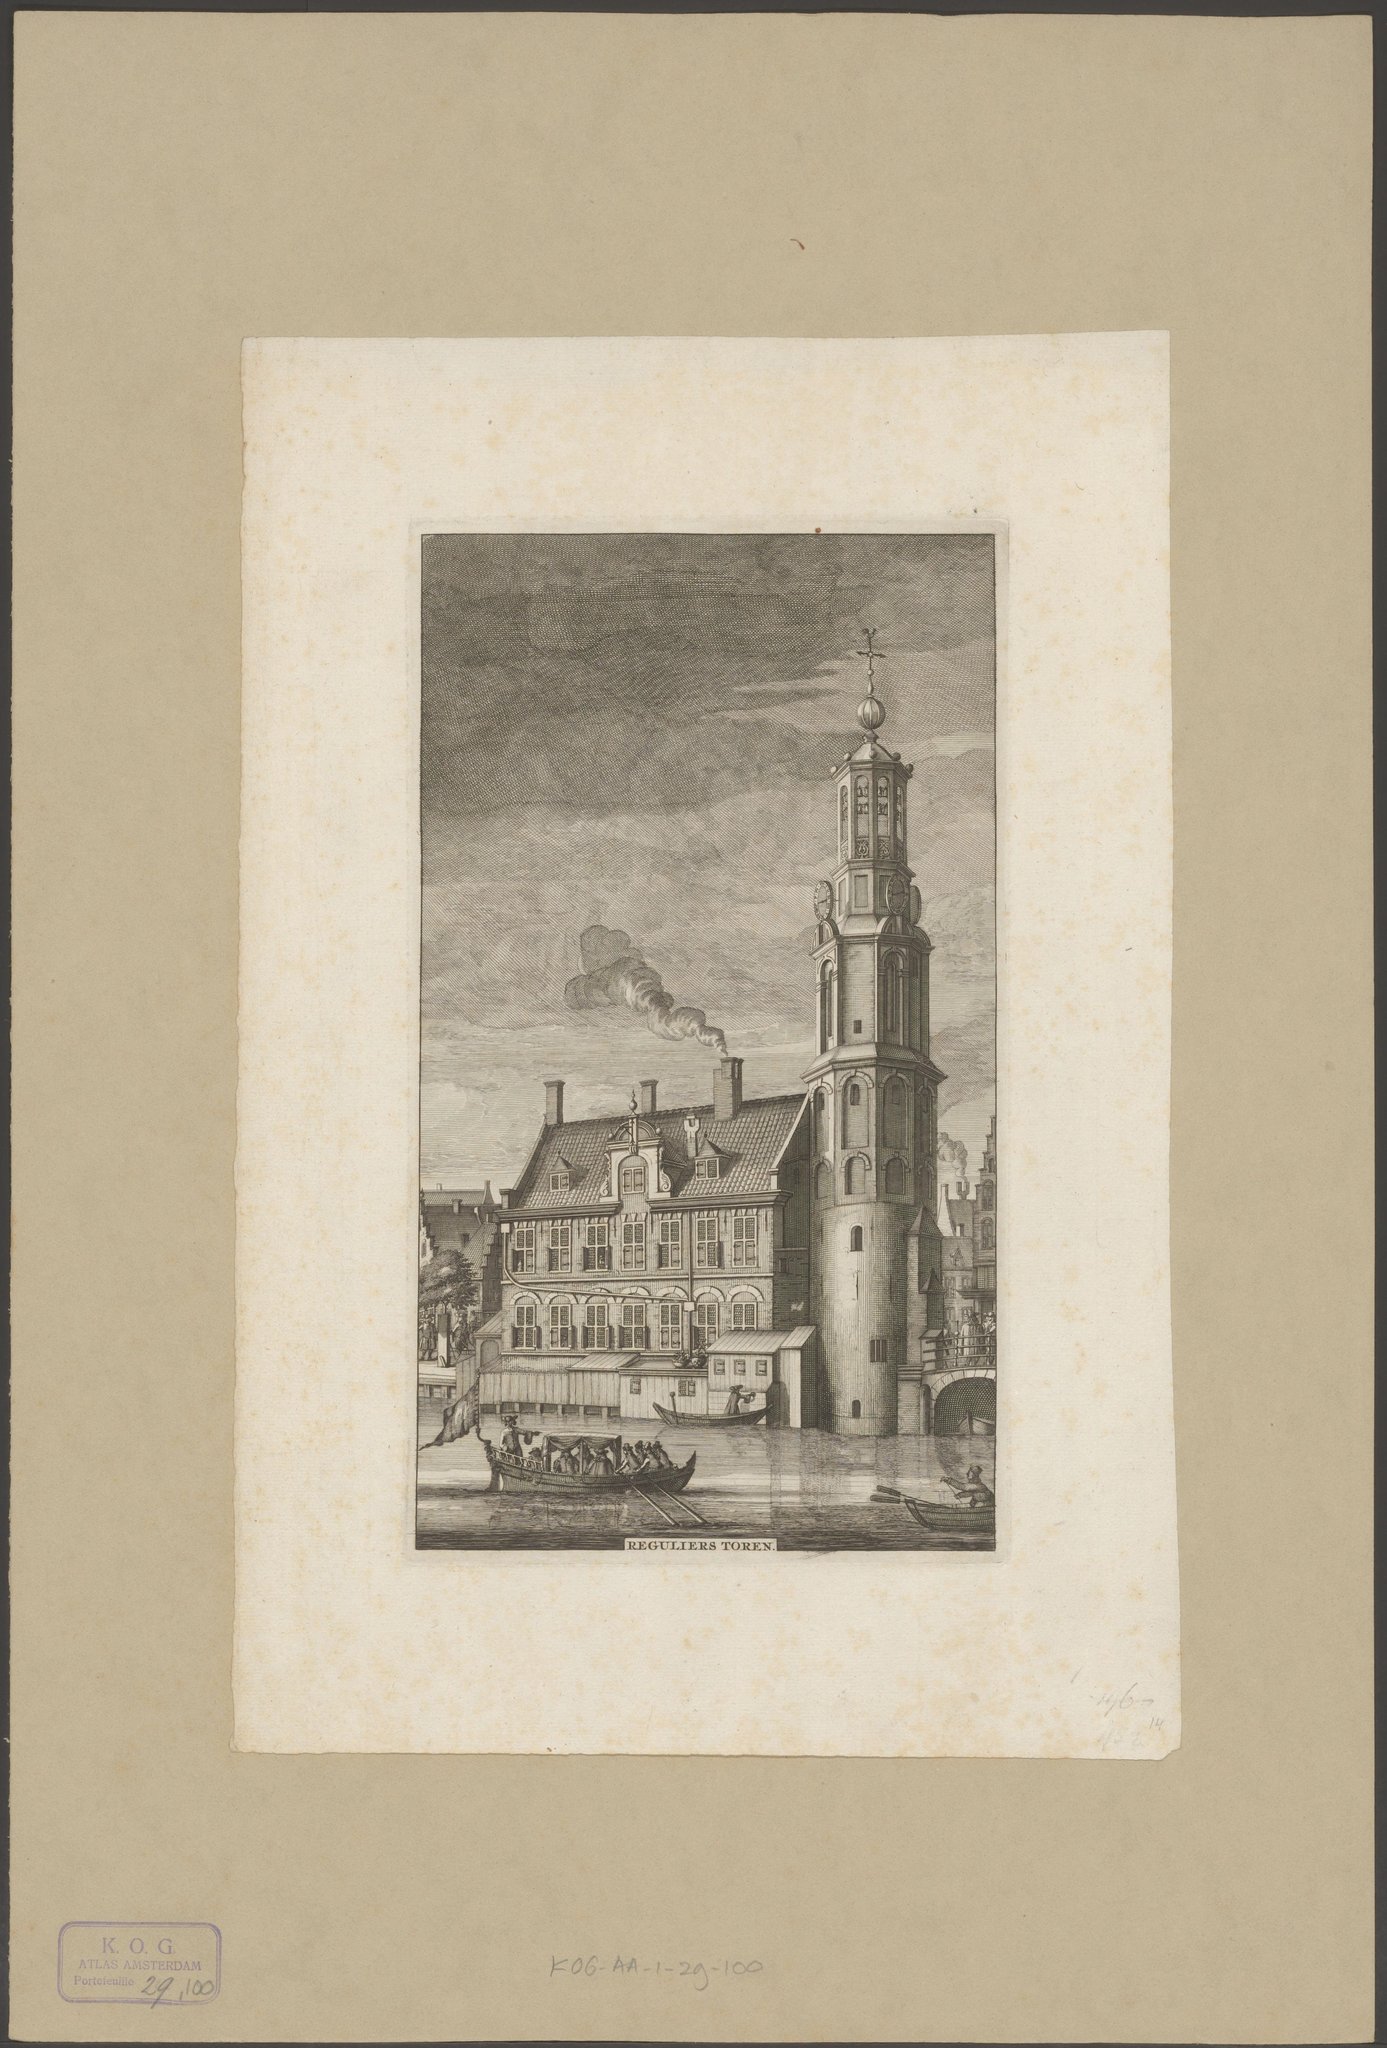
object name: print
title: Gezicht op de Munttoren te Amsterdam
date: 1726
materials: paper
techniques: engraving, etching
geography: amsterdam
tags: tower, clock tower ~ monumental adornment, rowing-boat, canoe, etc., canals, waters (in city) (+ city(-scape) with figures, staffage)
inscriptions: collector's mark: Lugt 1641b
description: Prent mogelijk uit: Commelin, Casparus. Beschryvinge van Amsterdam (…). 2de druk. Amsterdam: Andries van Damme, Johannes Ratelband, weduwe Antony van Aeltwijk en Hermanus Uytwerf, 1726, dl. 2.